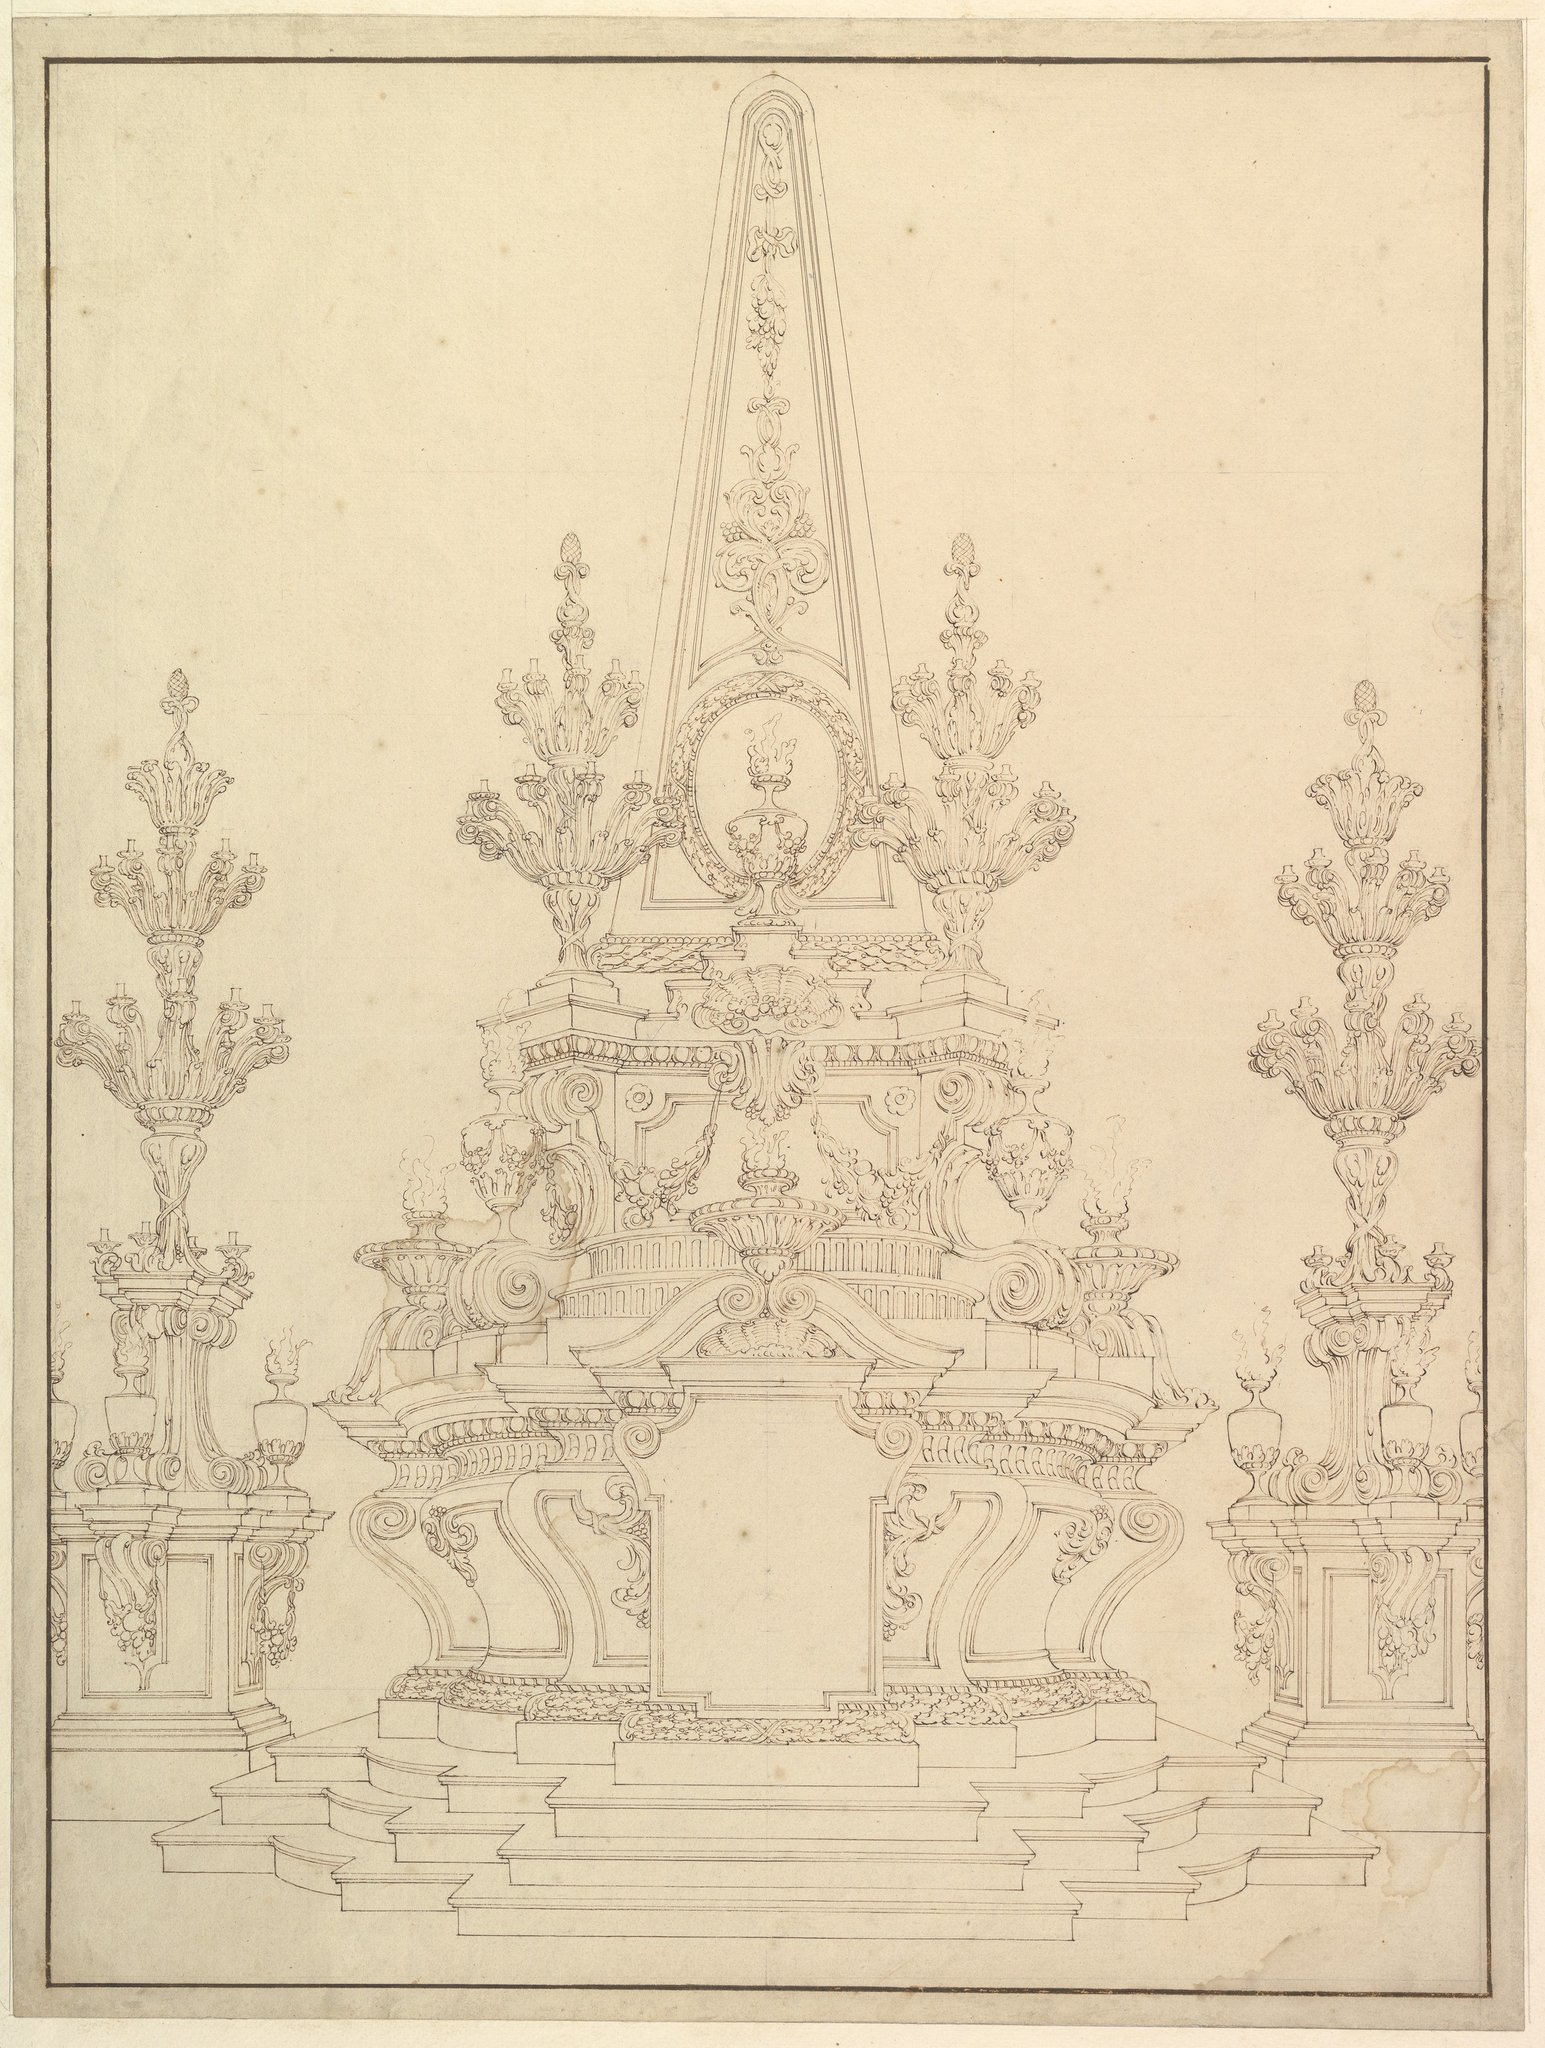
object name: drawing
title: Elevation of a Catafalque: Two Pedestals with Candelabra at Sides; with Central Obelisk Surrounded by Candelabra (recto); Sketch of architecture: archway and corner with pillars (verso)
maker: giuseppe galli bibiena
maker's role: artist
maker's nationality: italian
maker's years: 1696-1756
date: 1696-1756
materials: chalk, ink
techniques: pen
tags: architecture,obelisks